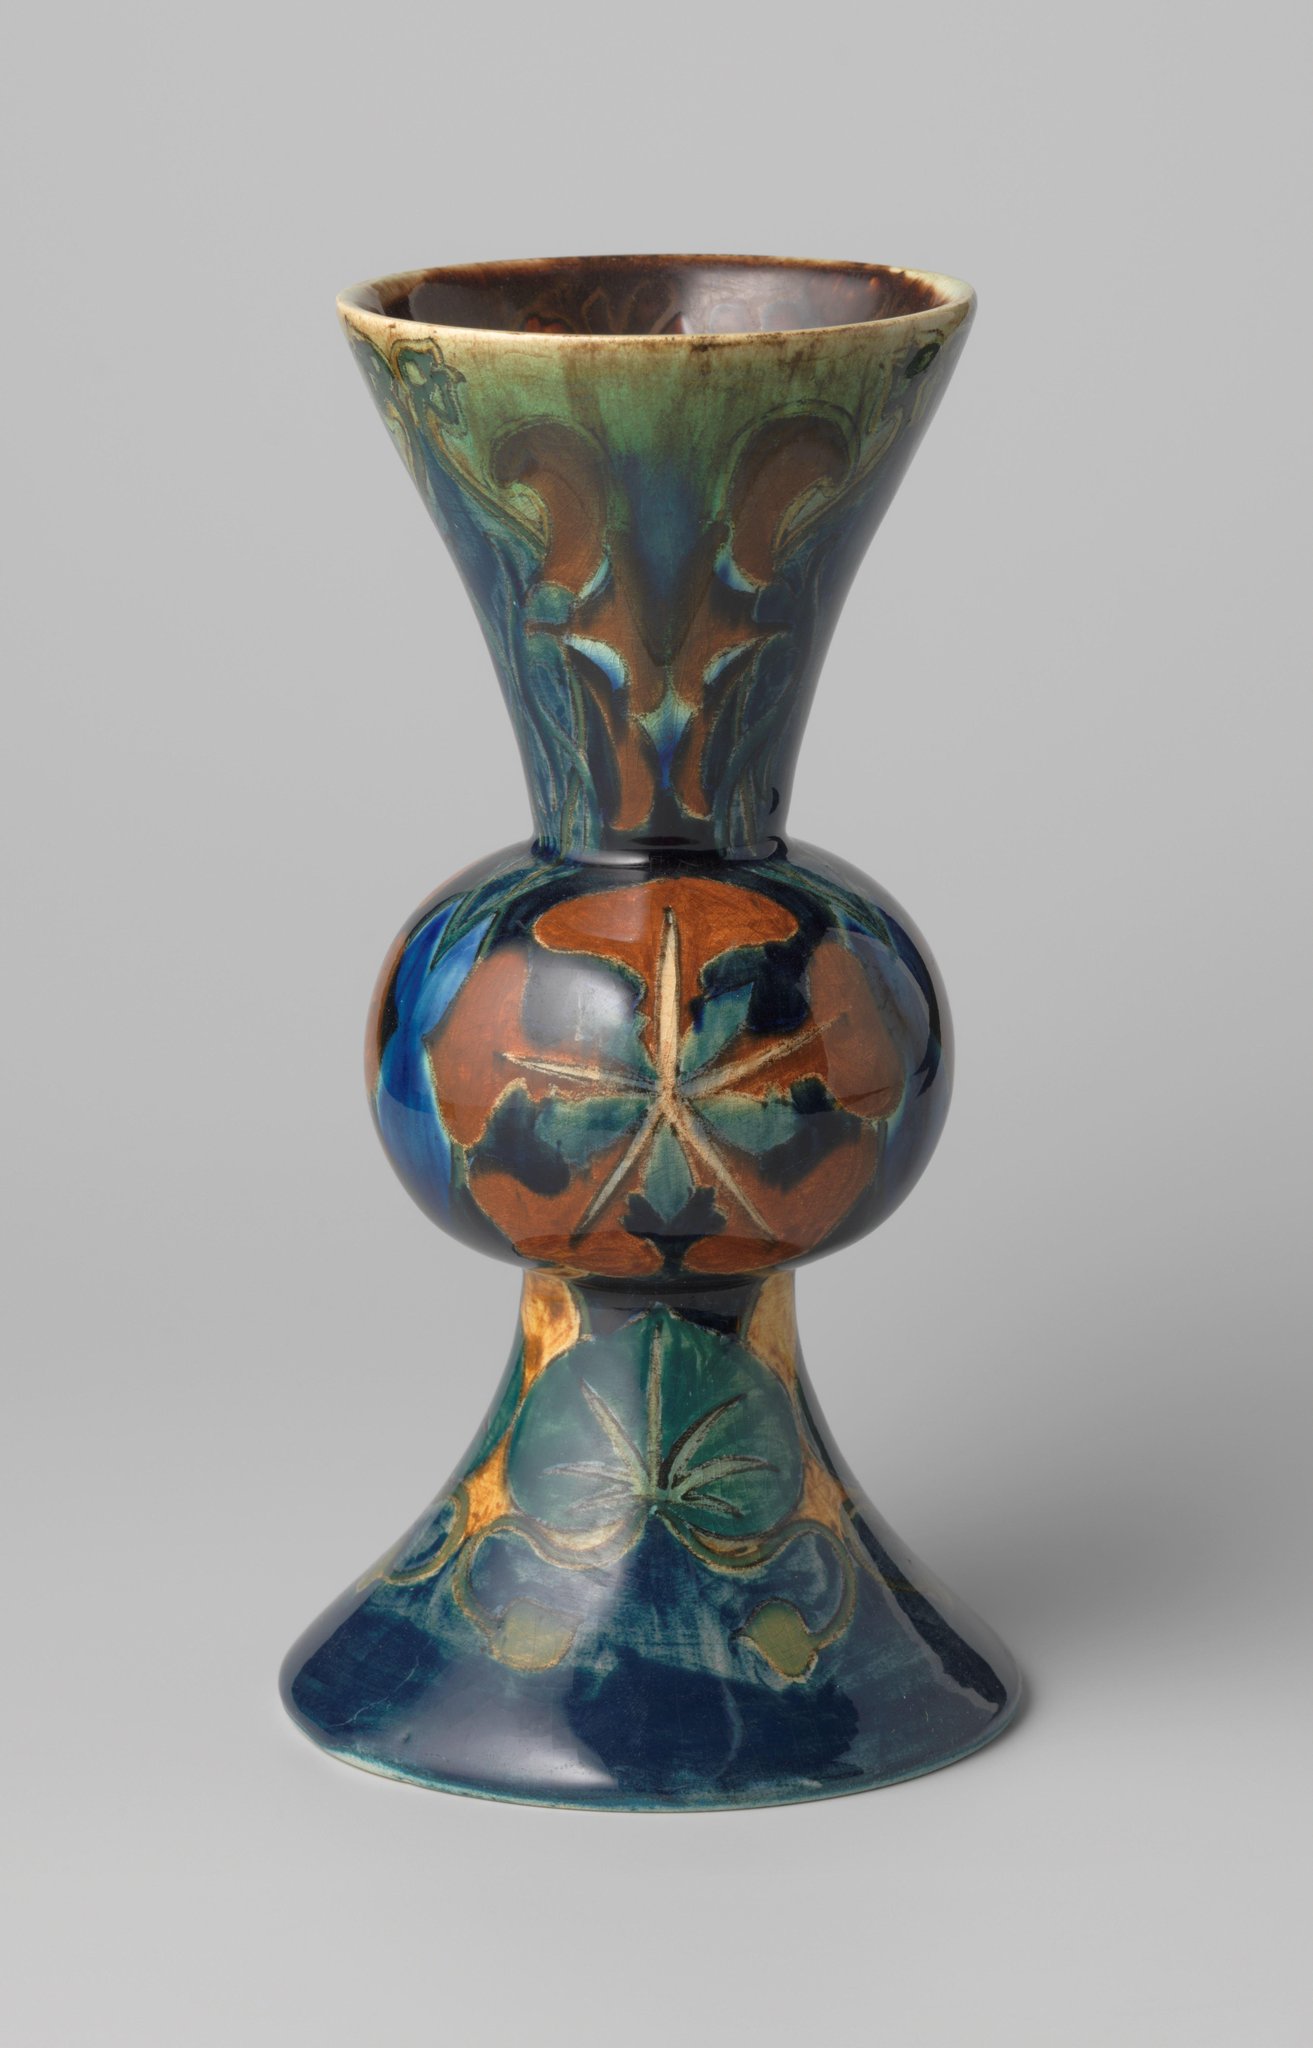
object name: vase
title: Vaas, diabolovormig met bolvormige nodus, beschilderd met plantenmotieven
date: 1896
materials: earthenware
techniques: painted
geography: the hague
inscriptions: mark: ‘Rozenburg // ooievaar // Den Haag (in zwart) ; jrl. NK symbool , 933 en ? (in bruin) ; 21 L (ingegrift)’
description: Vaas van aardewerk, diabolovormig met bolvormige nodus in het midden. Beschilderd met gestileerde plantenmotieven in geel, groen en bruin op donkerblauwe fond.